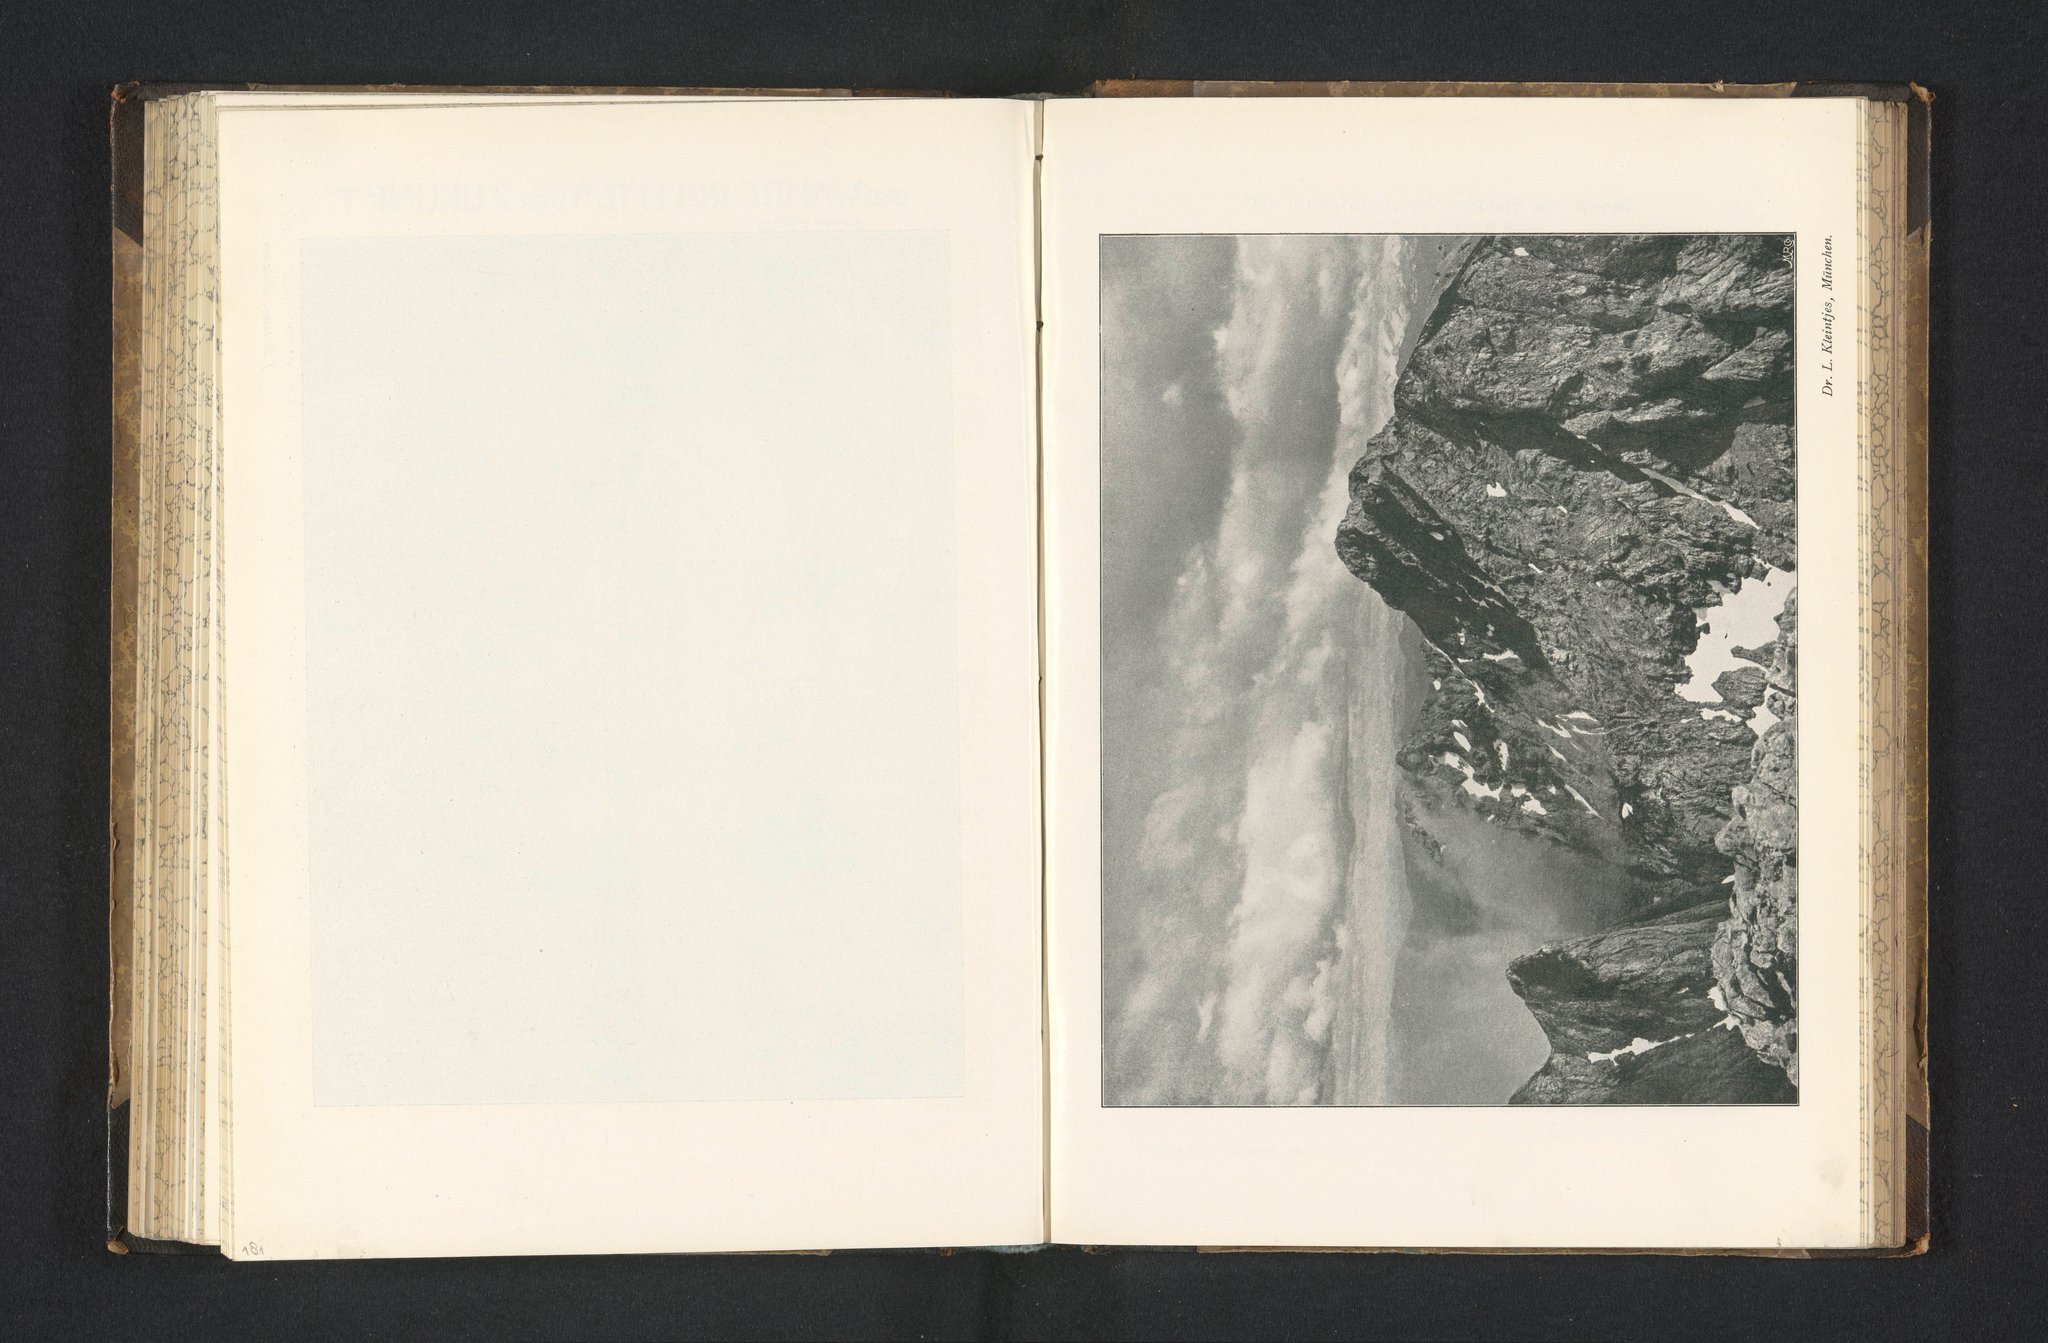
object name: page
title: Berglandschap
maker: l.l. kleintjes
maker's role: amateurfotograaf, arts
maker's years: 1875-1948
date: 1898-1903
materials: paper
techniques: autotype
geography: berlin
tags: mountains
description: Prent op vierde ongenummerde pagina na pagina 290.